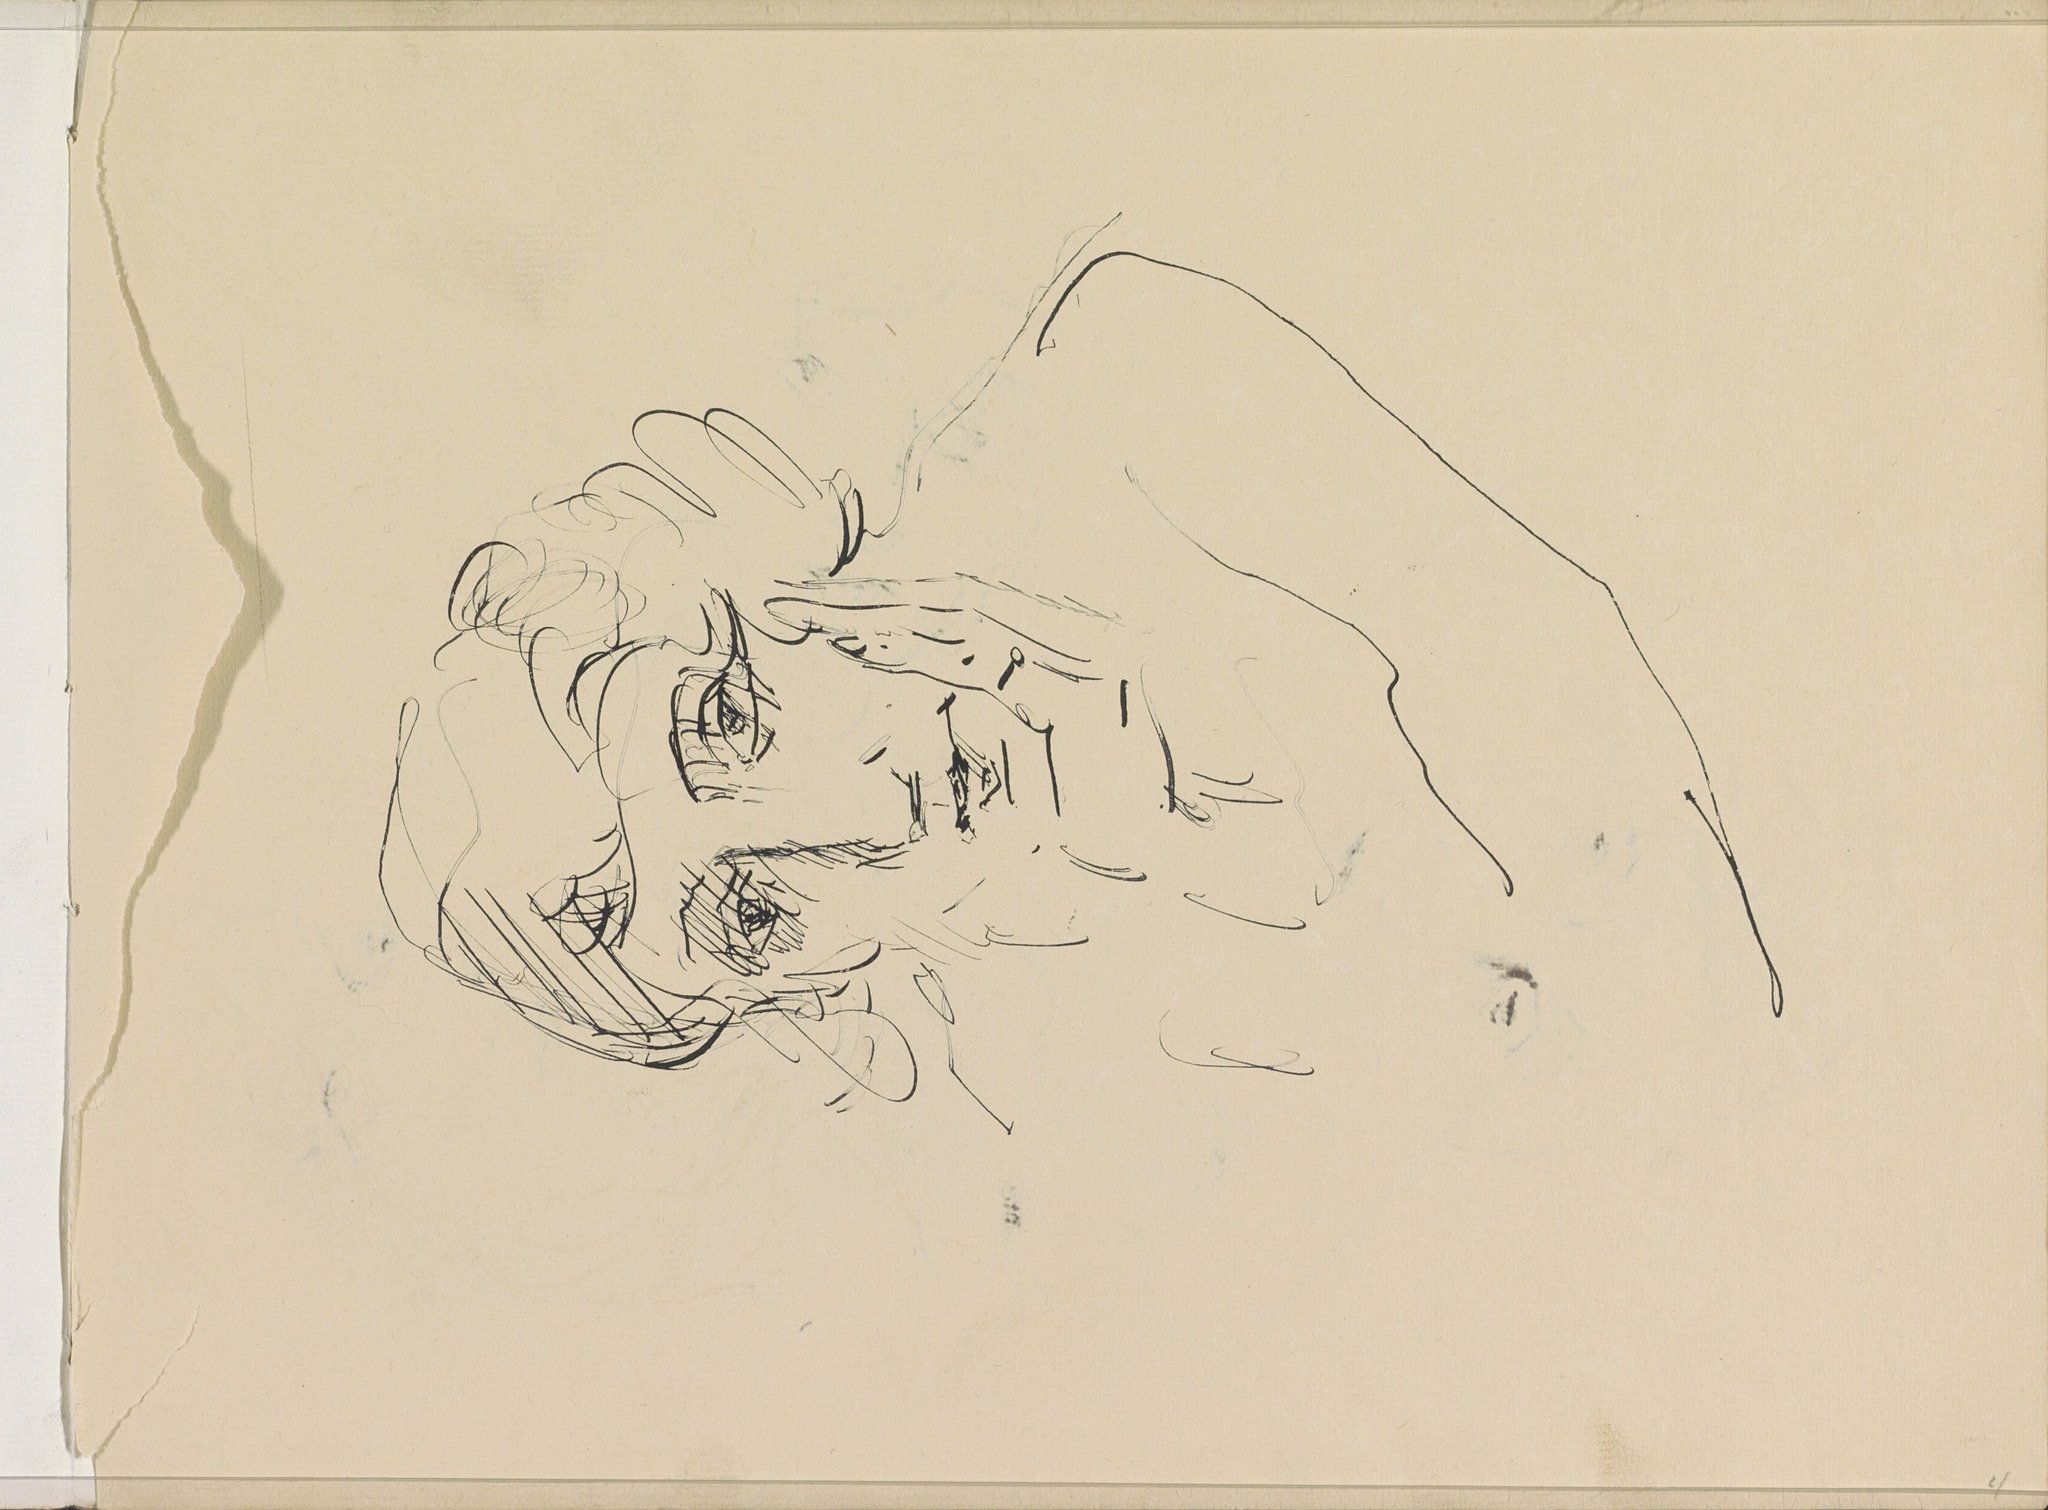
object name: sketchbook leaf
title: Vrouw met een hand onder haar kin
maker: isaac israels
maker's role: draughtsman, painter, print maker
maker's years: 1865-1934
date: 1875-1934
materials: ink, paper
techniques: pen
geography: the hague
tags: adult woman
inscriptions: watermark: ‘Ingres’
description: Blad 4 recto uit schetsboek IV met 27 bladen.